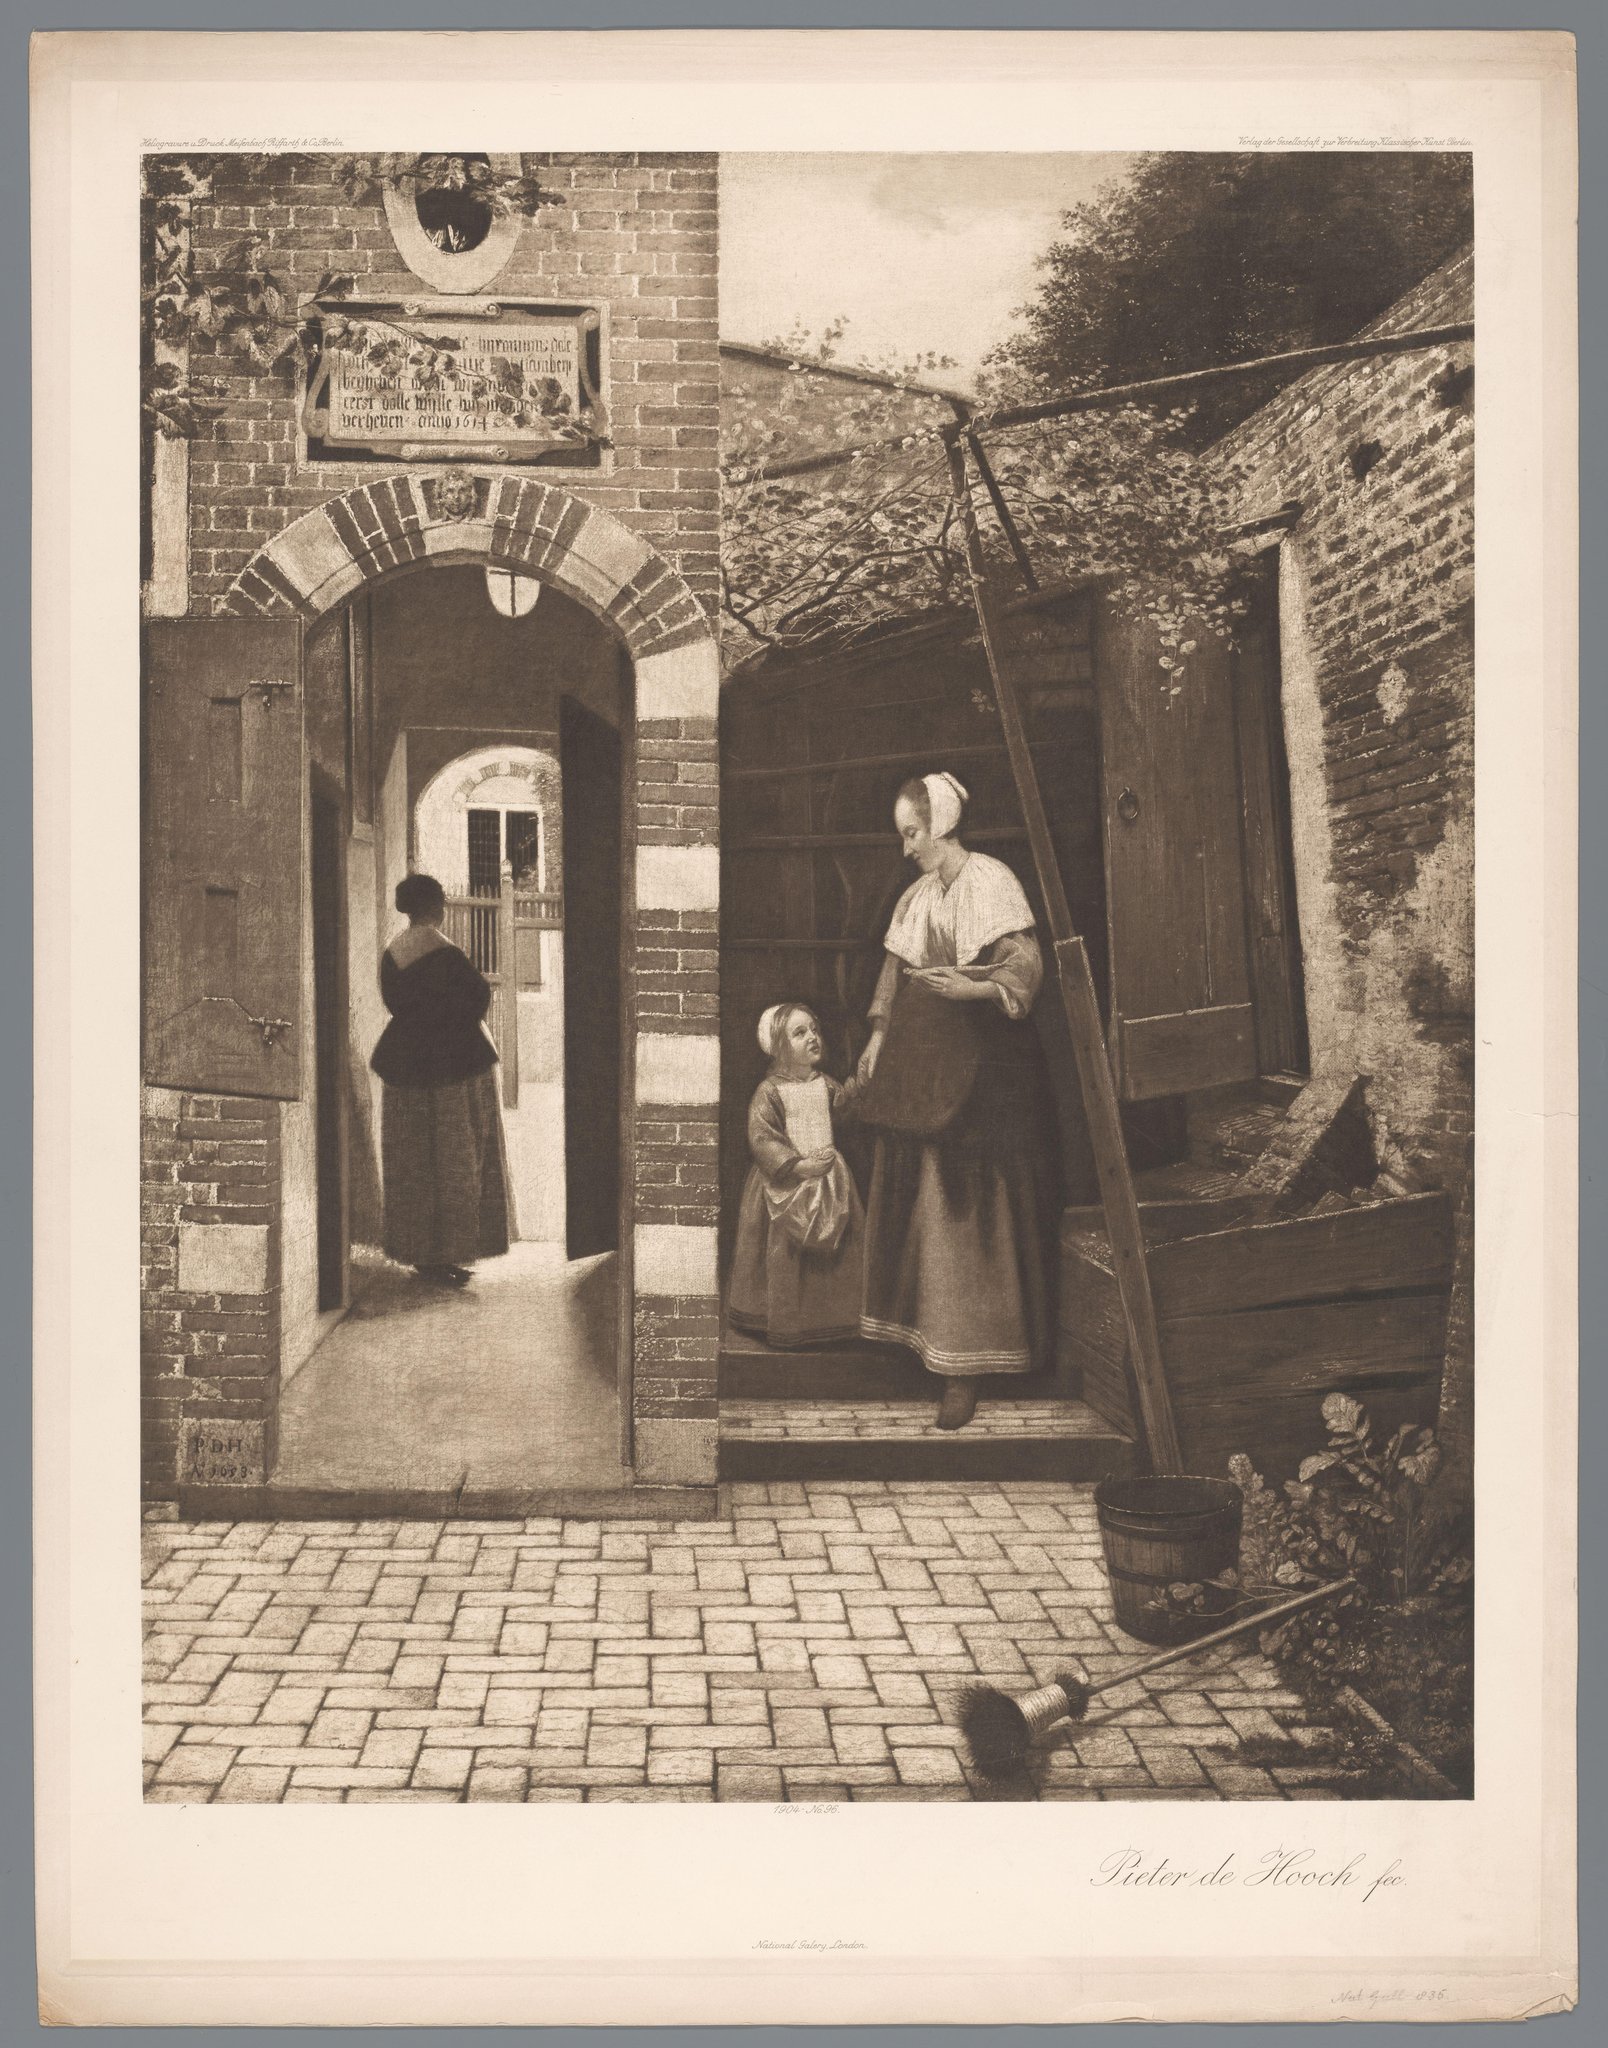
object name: fotomechanisch procedé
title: Fotoreproductie van schilderij De binnenplaats van een huis in Delft door Pieter de Hooch, coll. National Gallery, Londen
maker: Anonymous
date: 1904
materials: cardboard, paper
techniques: photoaquatint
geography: berlin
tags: picture, painting